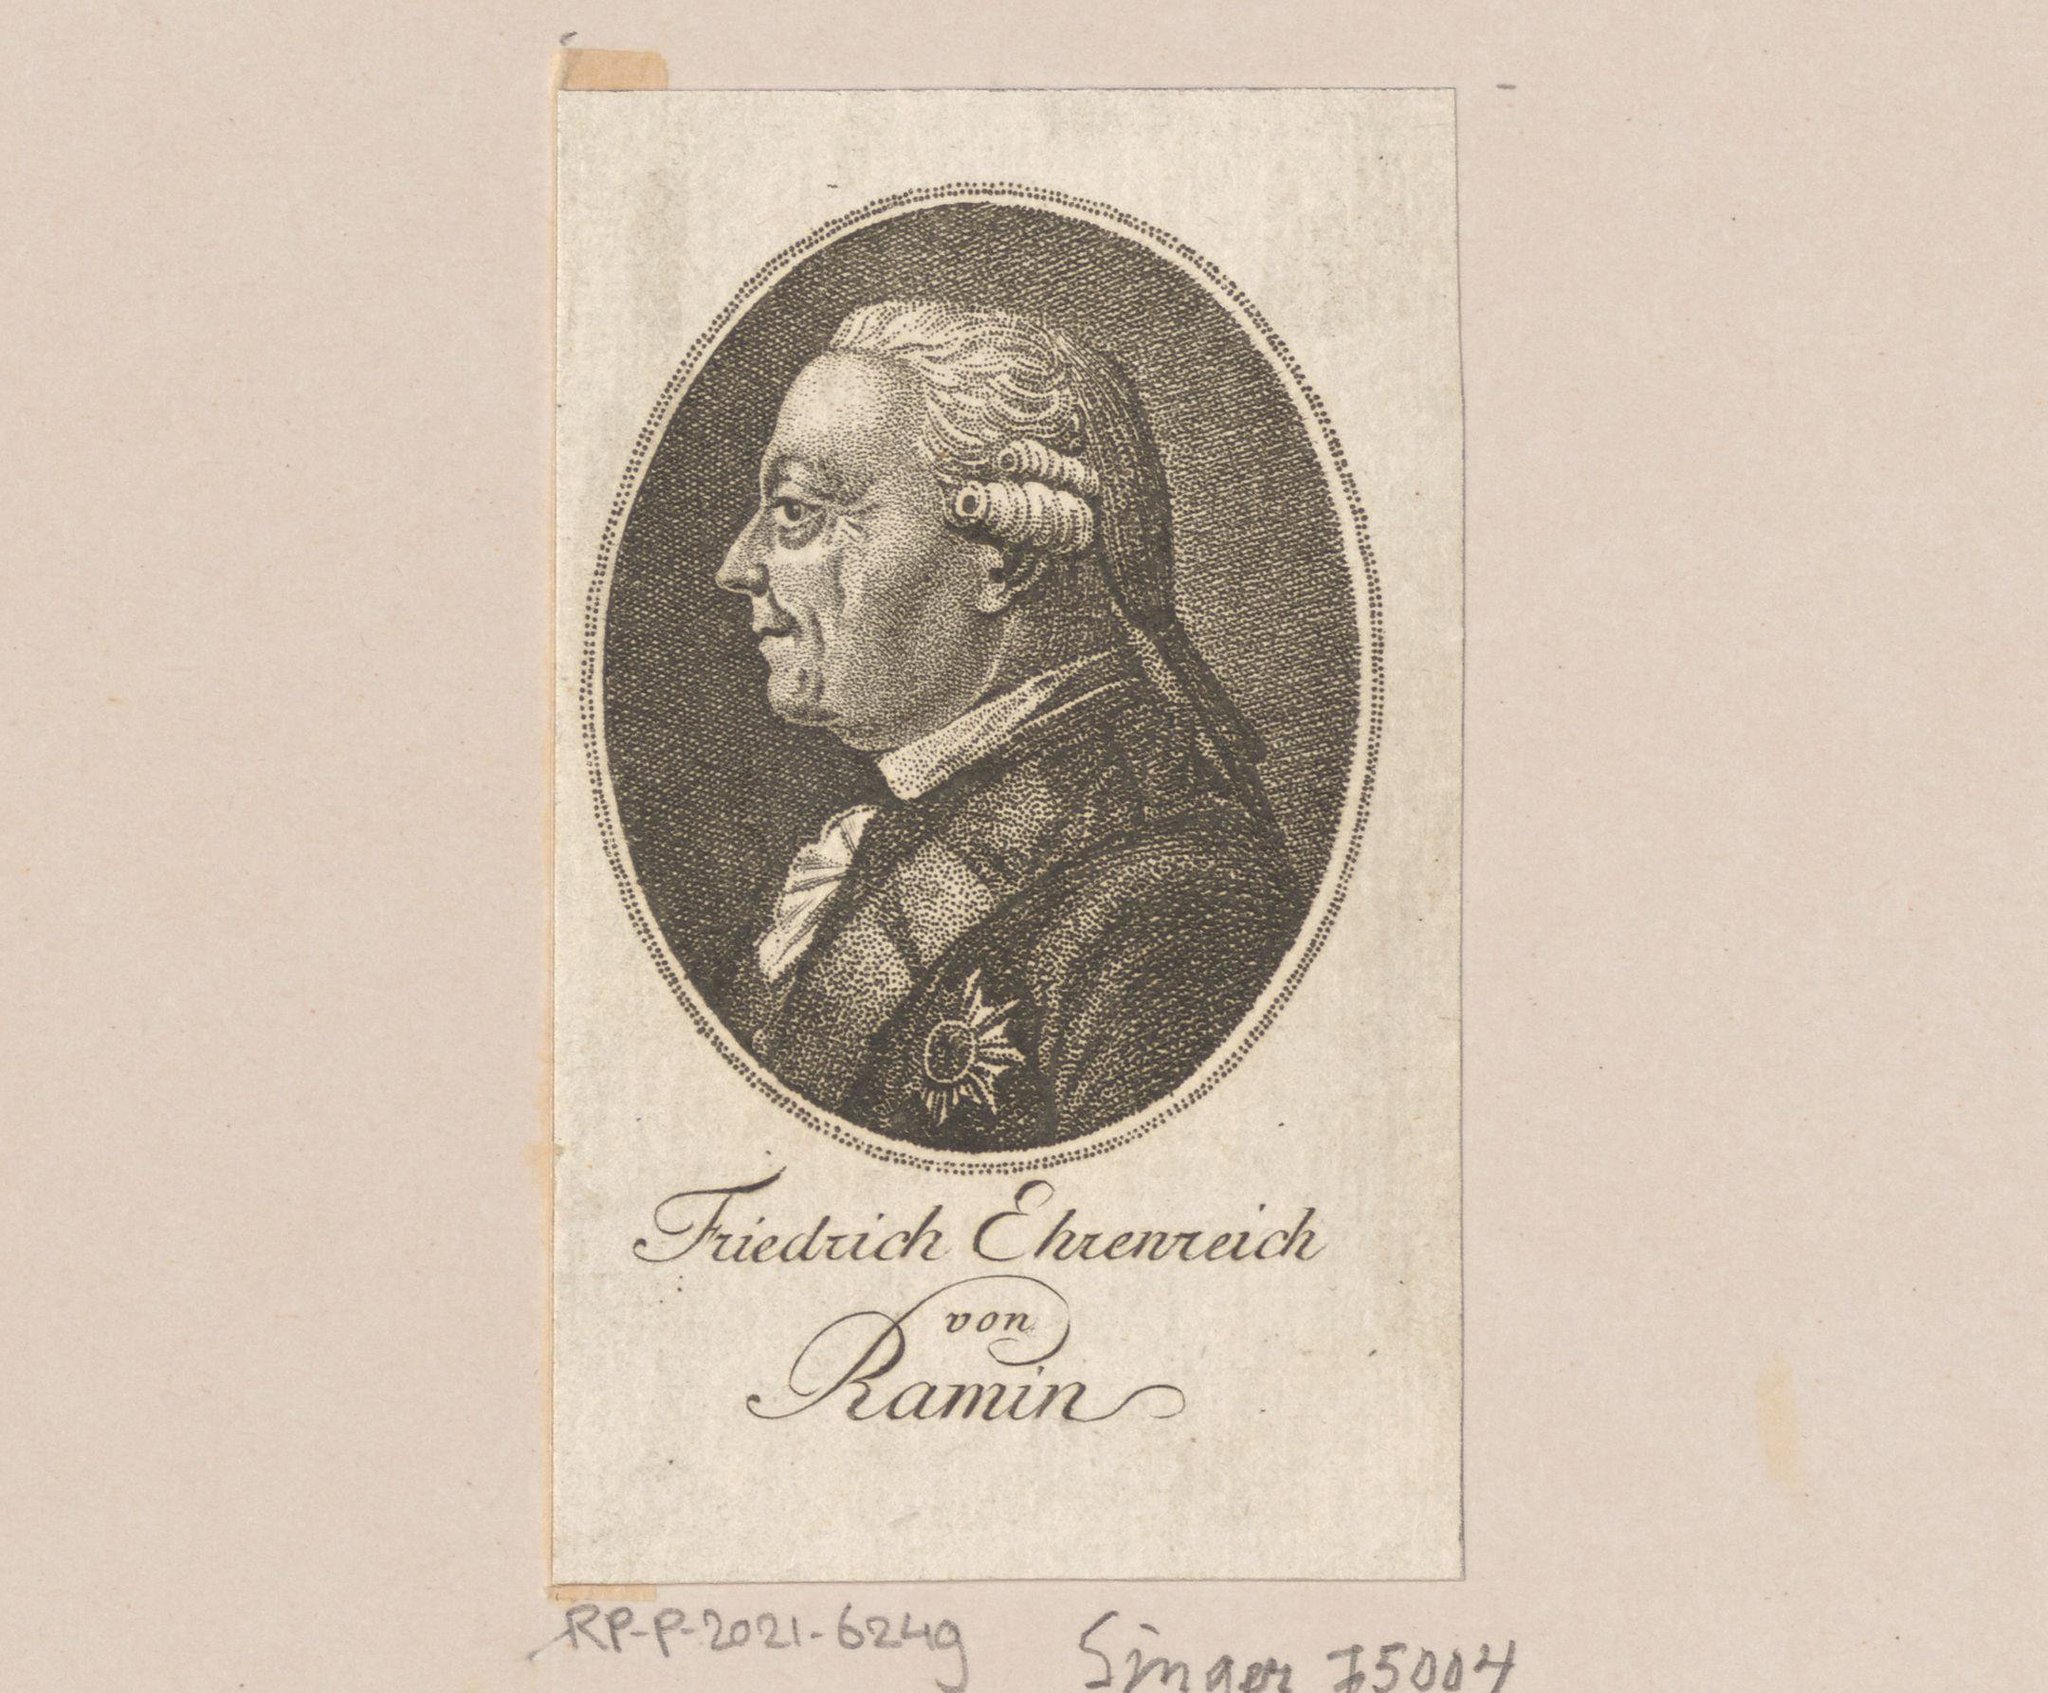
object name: print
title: Portret van Friedrich Ehrenreich von Ramin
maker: Anonymous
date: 1750-1799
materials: paper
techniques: engraving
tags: berlin, historical persons, medals and other marks of military honour